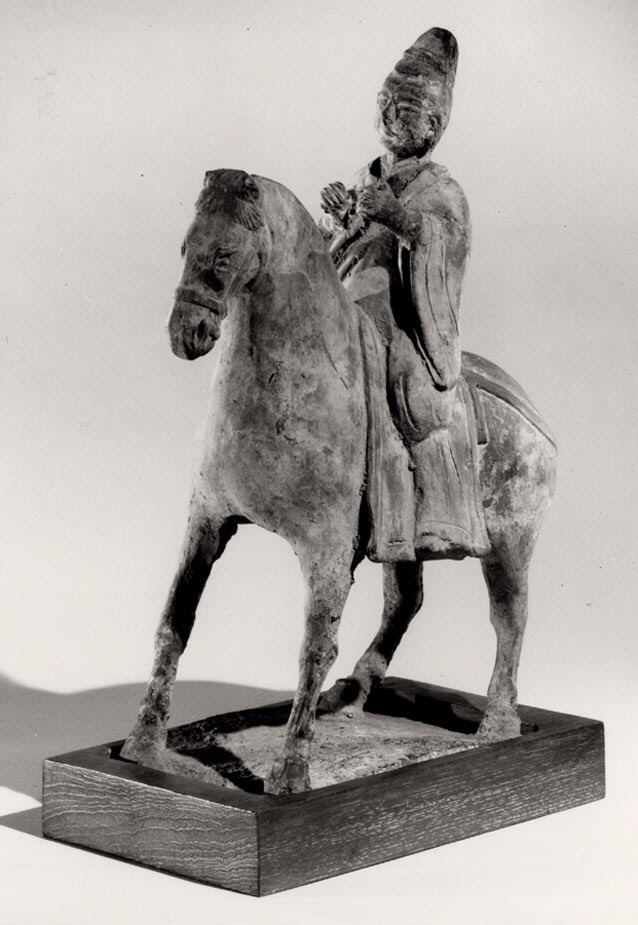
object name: figure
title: Official on Horseback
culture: chinese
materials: earthenware, pigment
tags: men,horses